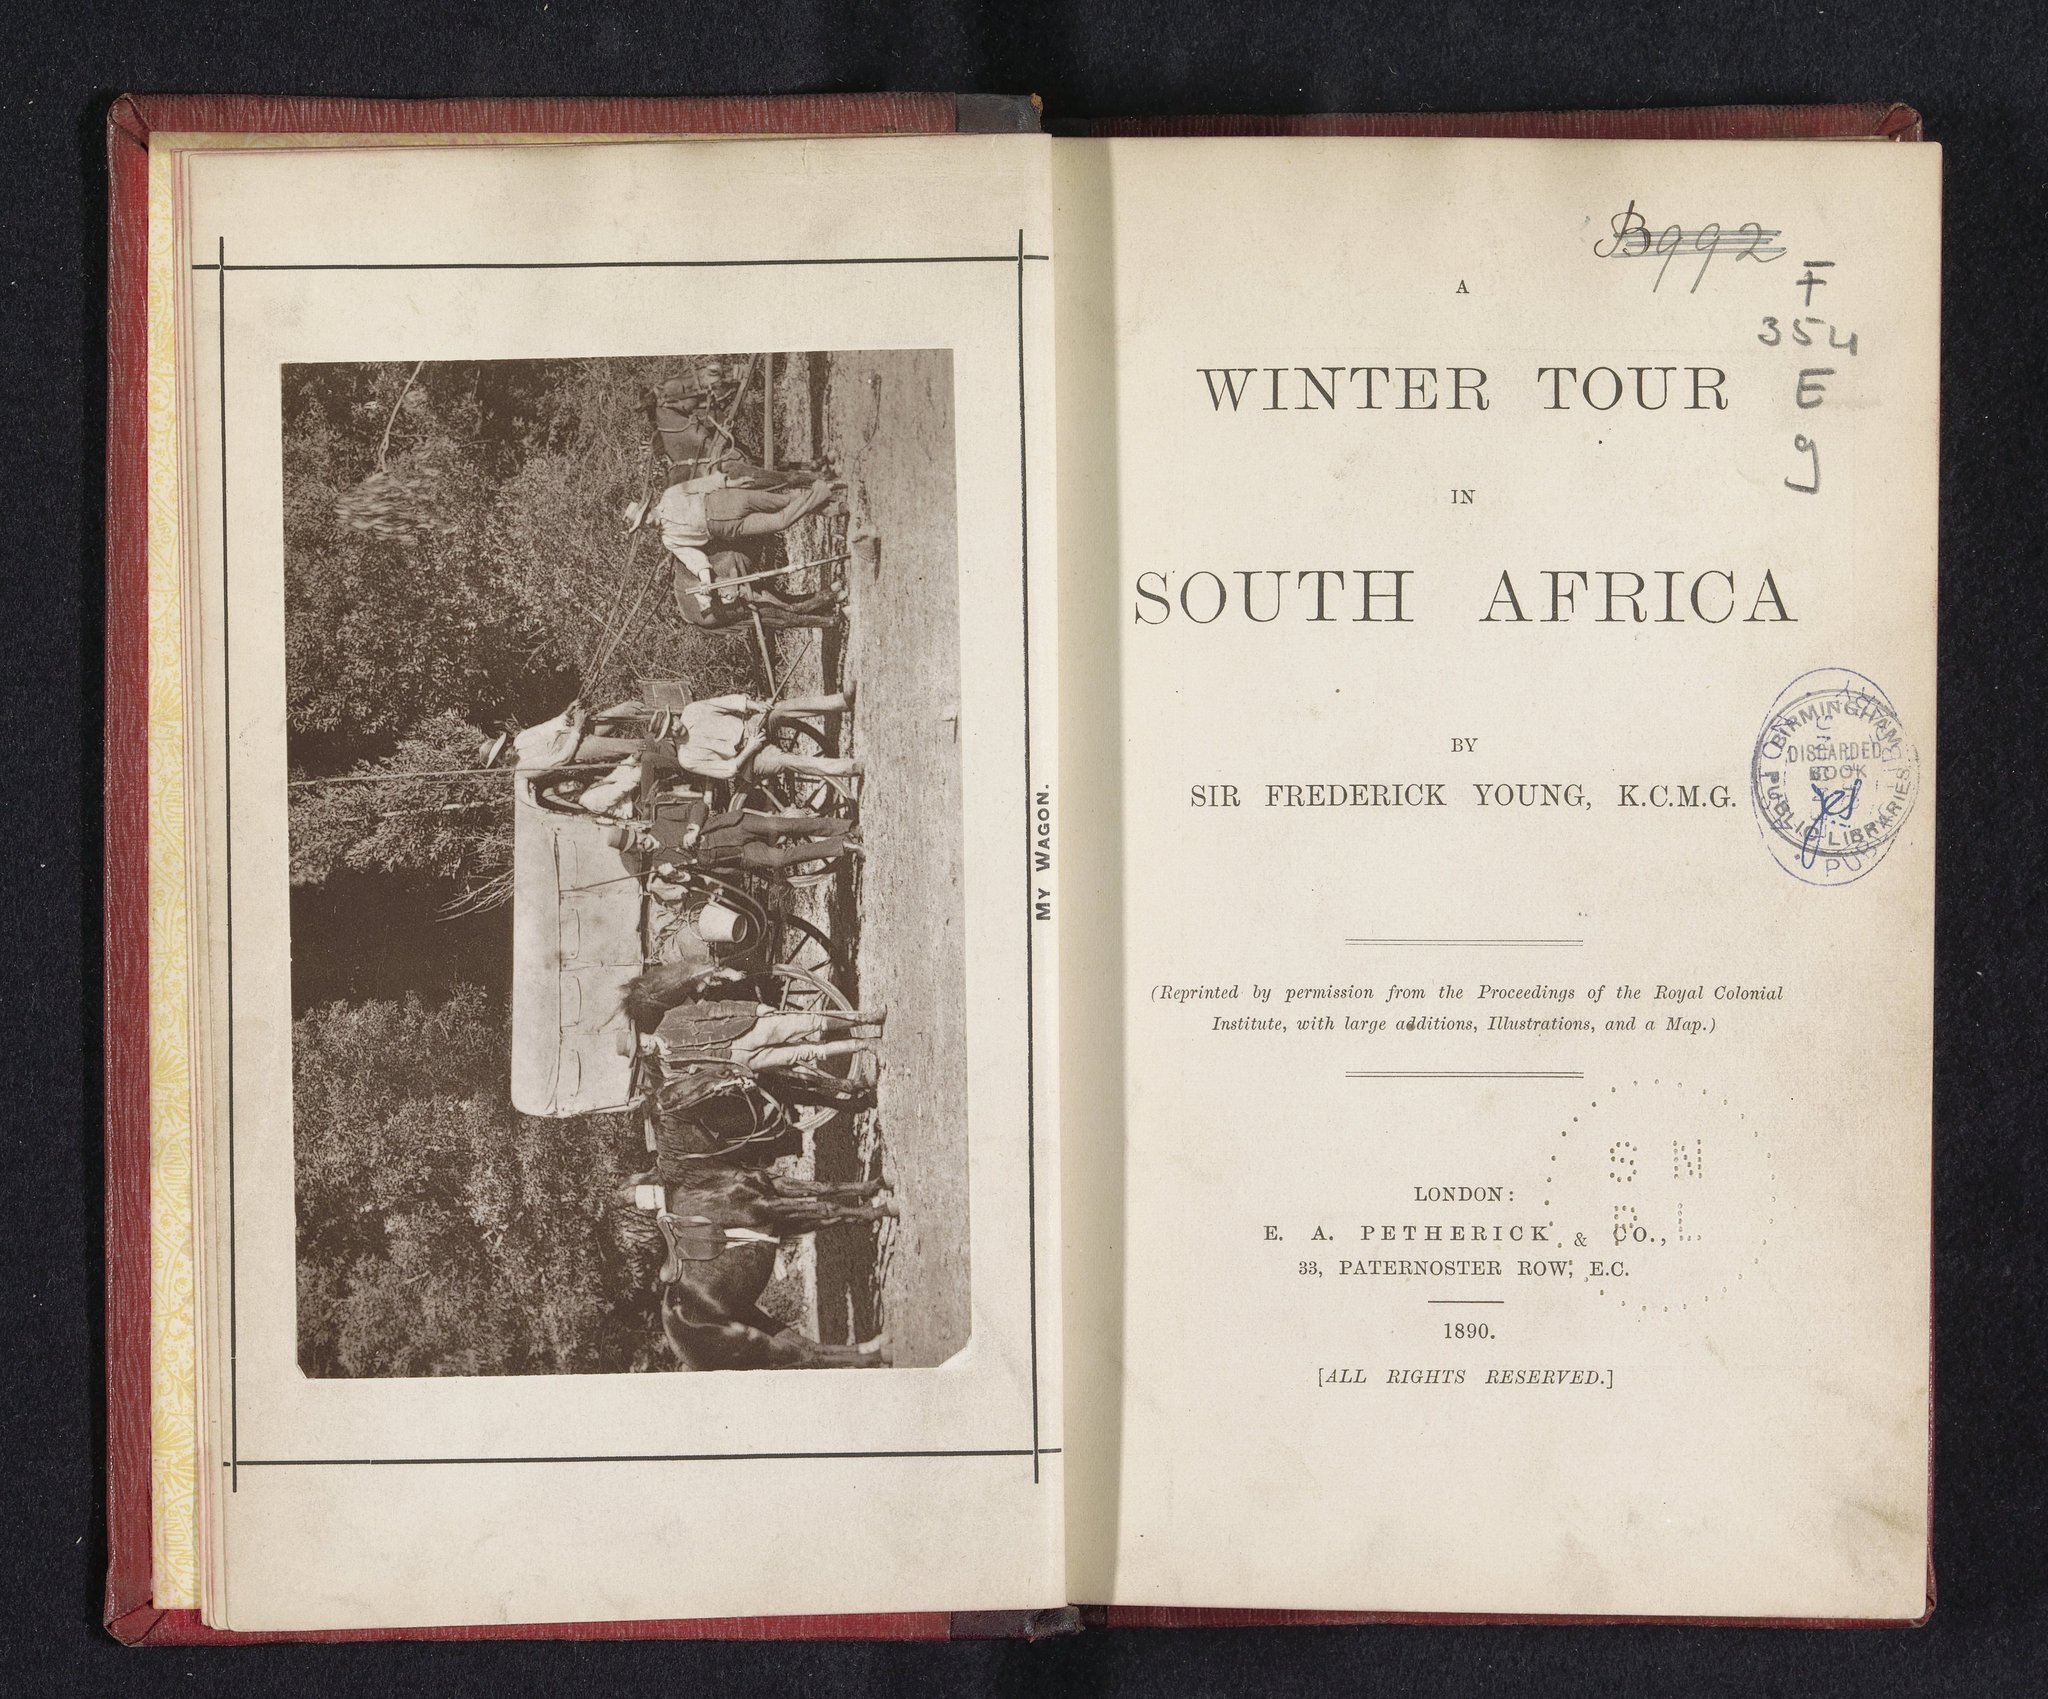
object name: page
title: My wagon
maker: Anonymous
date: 1888-1890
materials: paper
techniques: woodburytype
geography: south africa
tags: frederick young, four-wheeled, animal-drawn vehicle, e.g.: cab, carriage, coach, horse